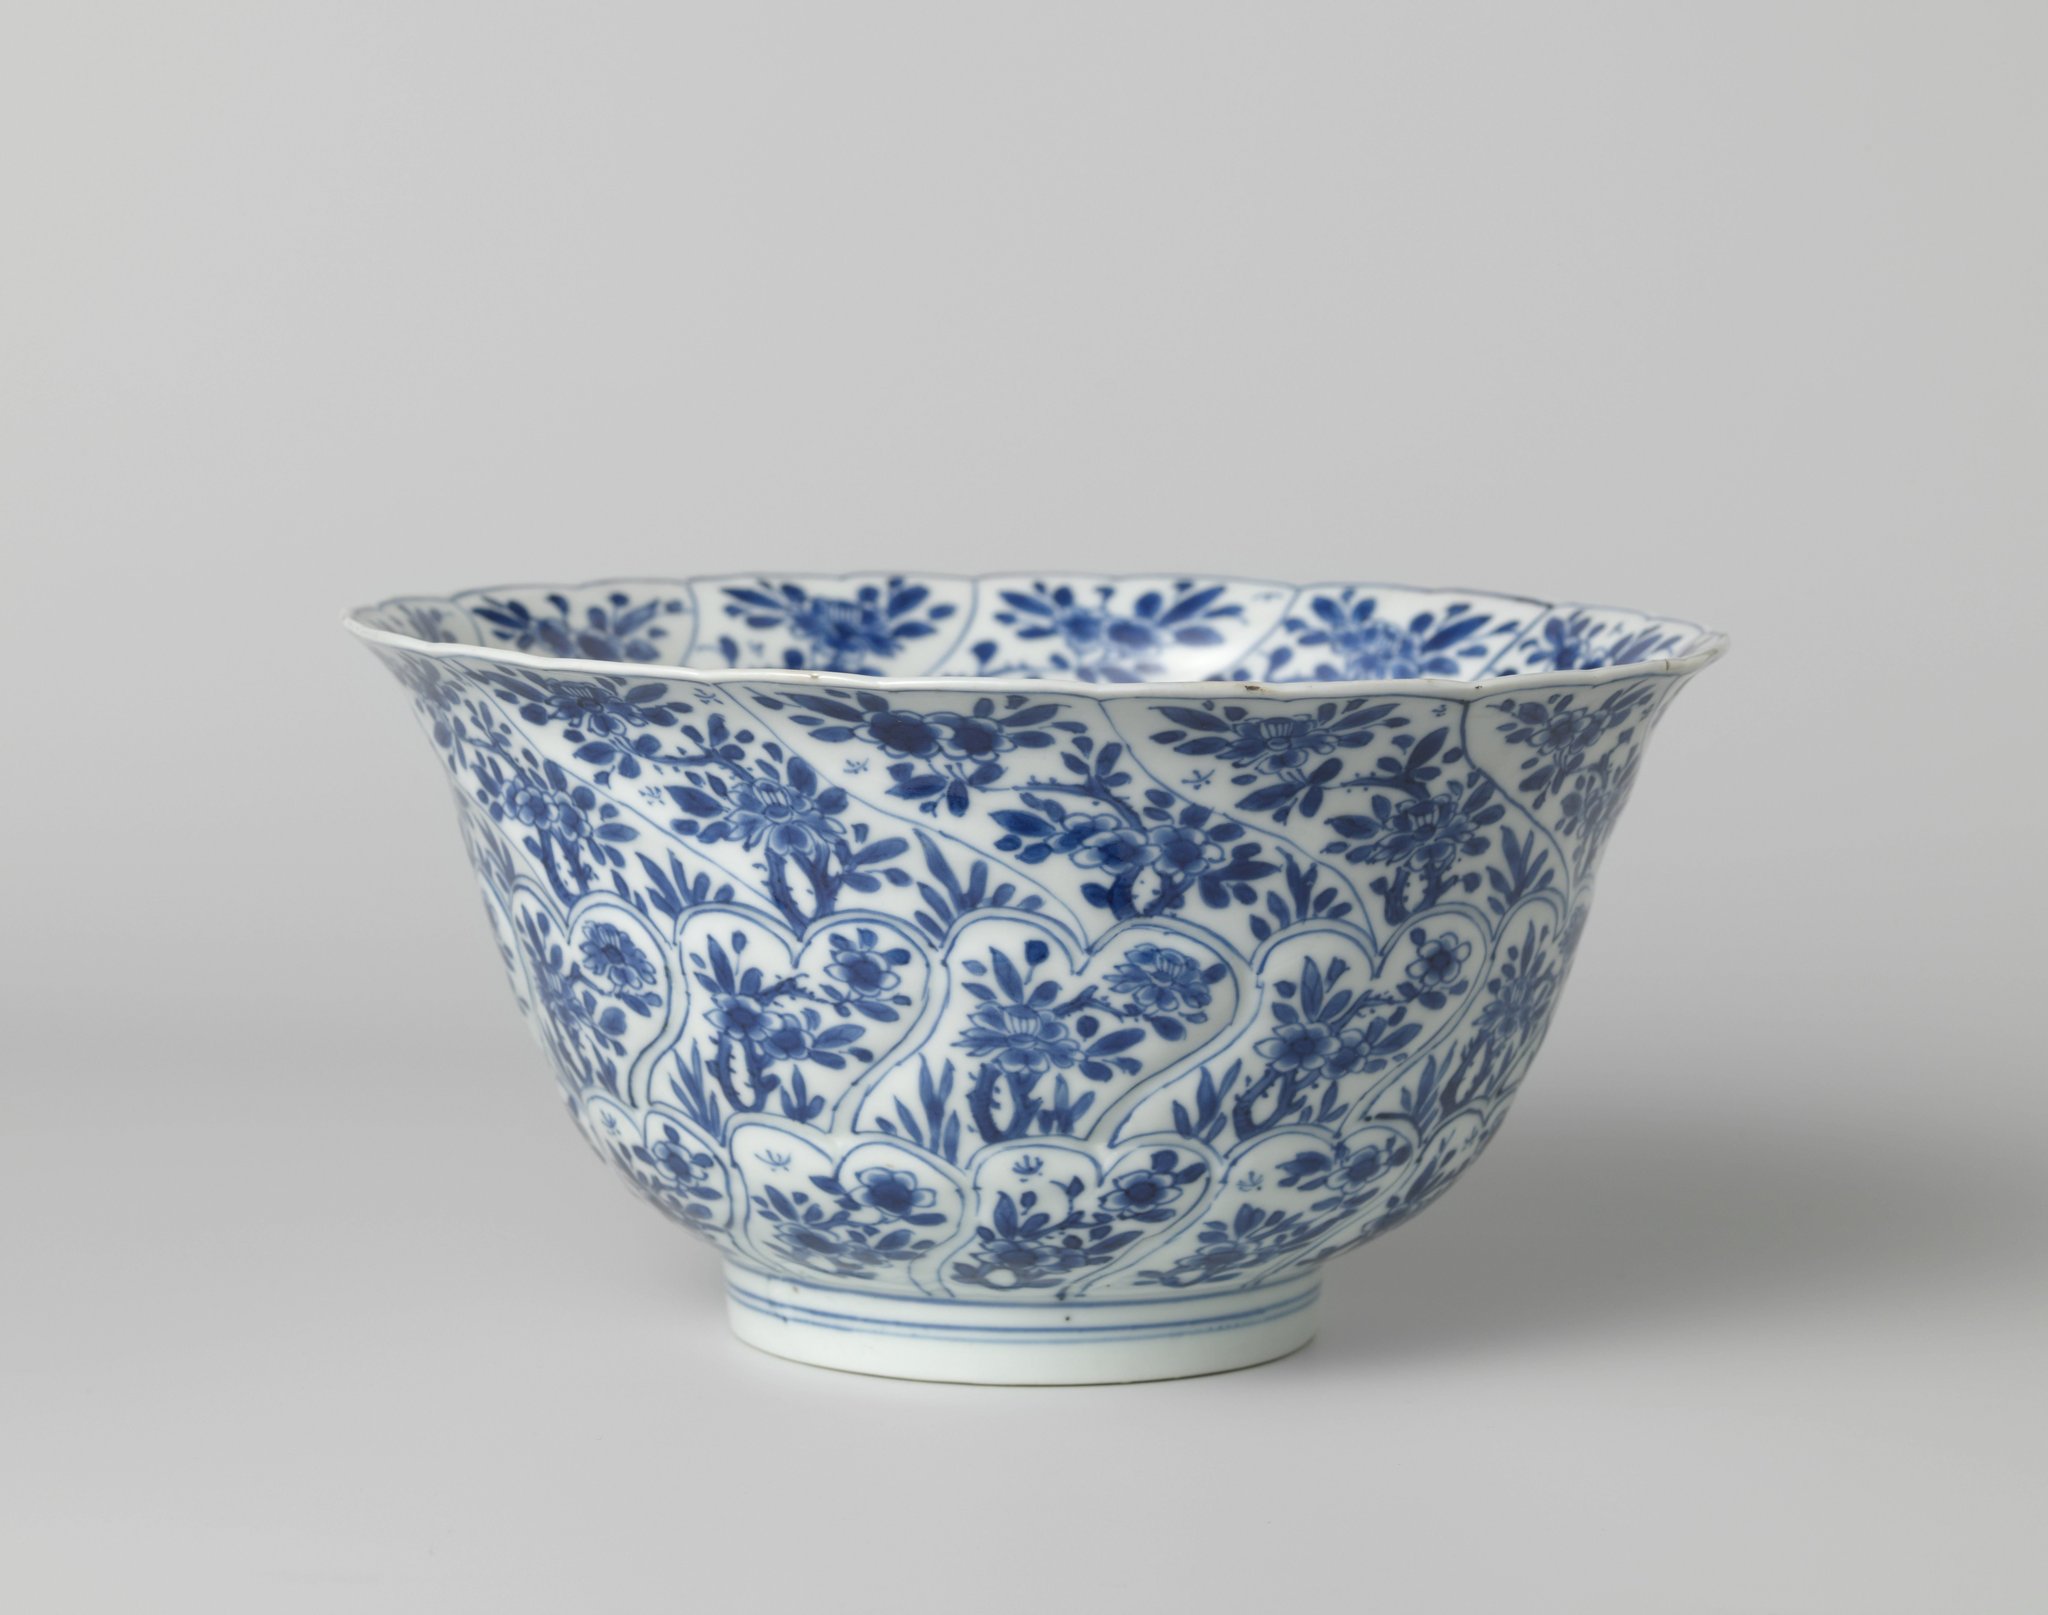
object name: bowl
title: Bowl with three rows of twisted panels with flower sprays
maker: Anonymous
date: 1680-1720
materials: cobalt, glaze, paint, porcelain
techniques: firing, turning, vitrification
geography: china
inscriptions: mark: ‘玉’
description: Twee rijen verhoogde schuine vakken omlijst door blauwe randen waarop telkens een tak met kleine bloemen en bladeren. Langs de mondrand die enigszins omgebogen en geschulpt is, zijn zowel binnen als buiten schuine takken in blauw aangebracht. Binnen de kom onder de blauwe rand twee rijen onversierde verdiepte vakken. Op de bodem in een dubbele cirkel een bloeiende struik en een kleine bamboeplant. Korte cilindrische voet met twee blauwe lijnen.